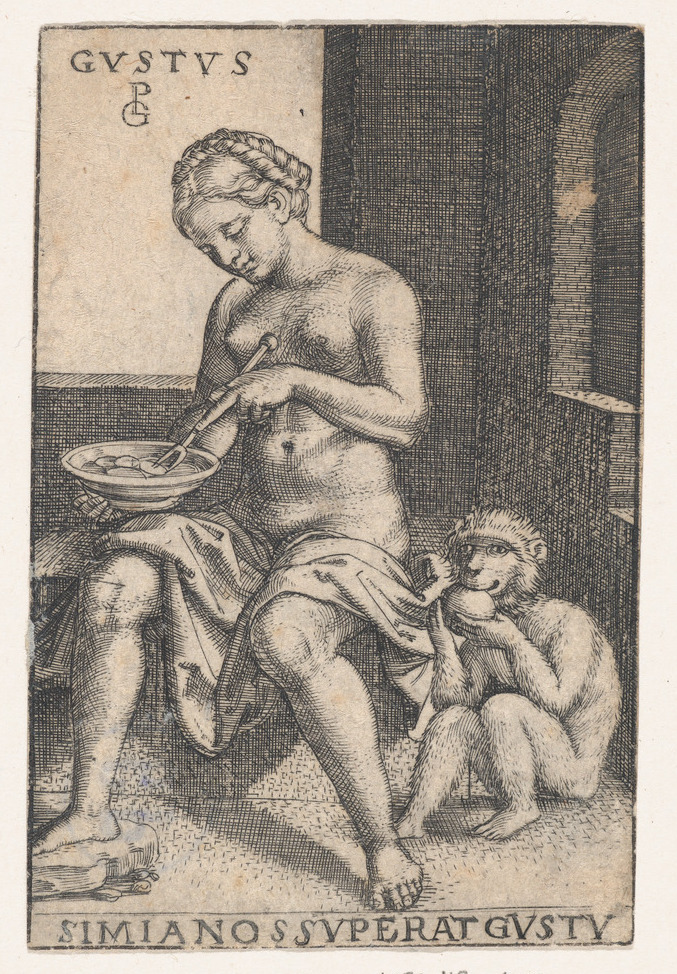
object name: print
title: Taste (Gustus), from "The Five Senses"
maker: georg pencz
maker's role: artist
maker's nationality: german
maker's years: 1500-1550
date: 1539-1549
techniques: engraving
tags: food,female nudes,monkeys,eating